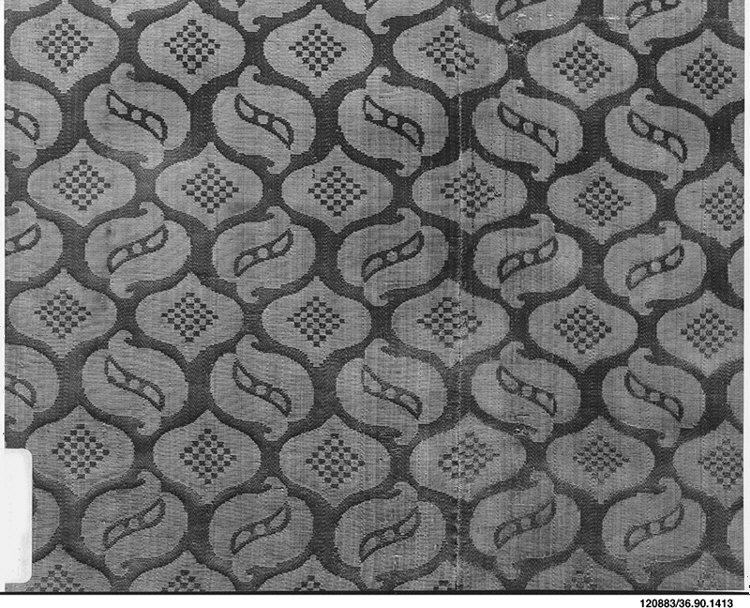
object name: piece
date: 1601-1700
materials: silk